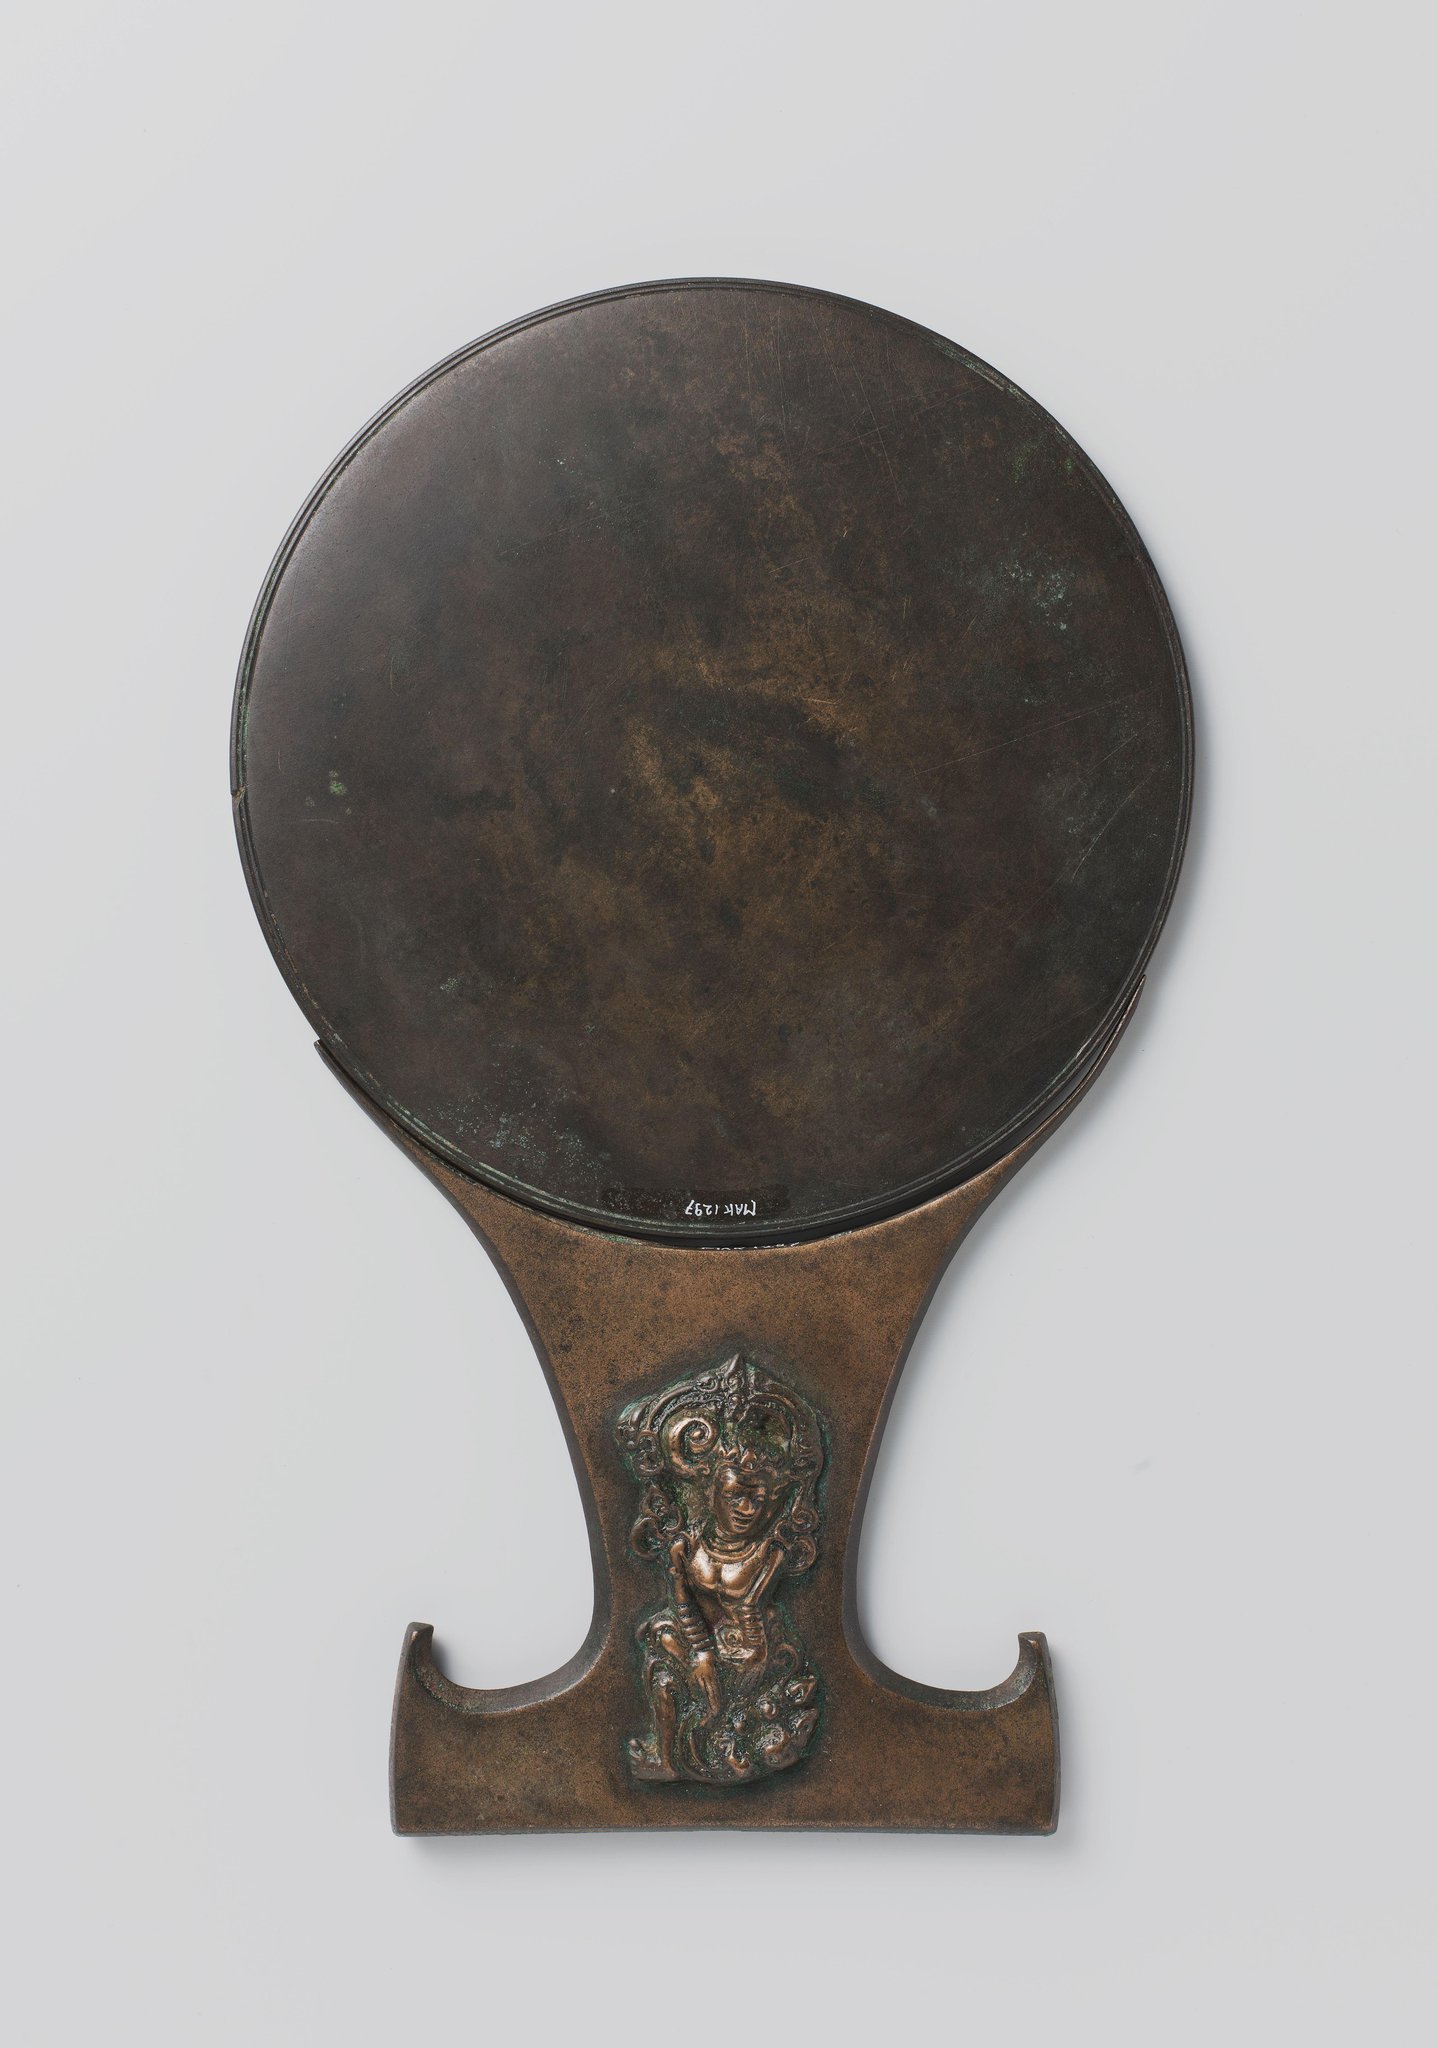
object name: handle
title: Mirrors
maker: Anonymous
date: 1300-1400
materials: bronze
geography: indonesia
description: In making these mirrors the disk and the handle were cast separately. The bronze disc was polished to a high shine and the handle adorned with decorative details, such as openwork motifs or gilded reliefs. Bronze mirrors could also have a ritual function, whereby the image of the divinity was reflected in the polished surface and thus establishing a connection between the spiritual and the mundane worlds.